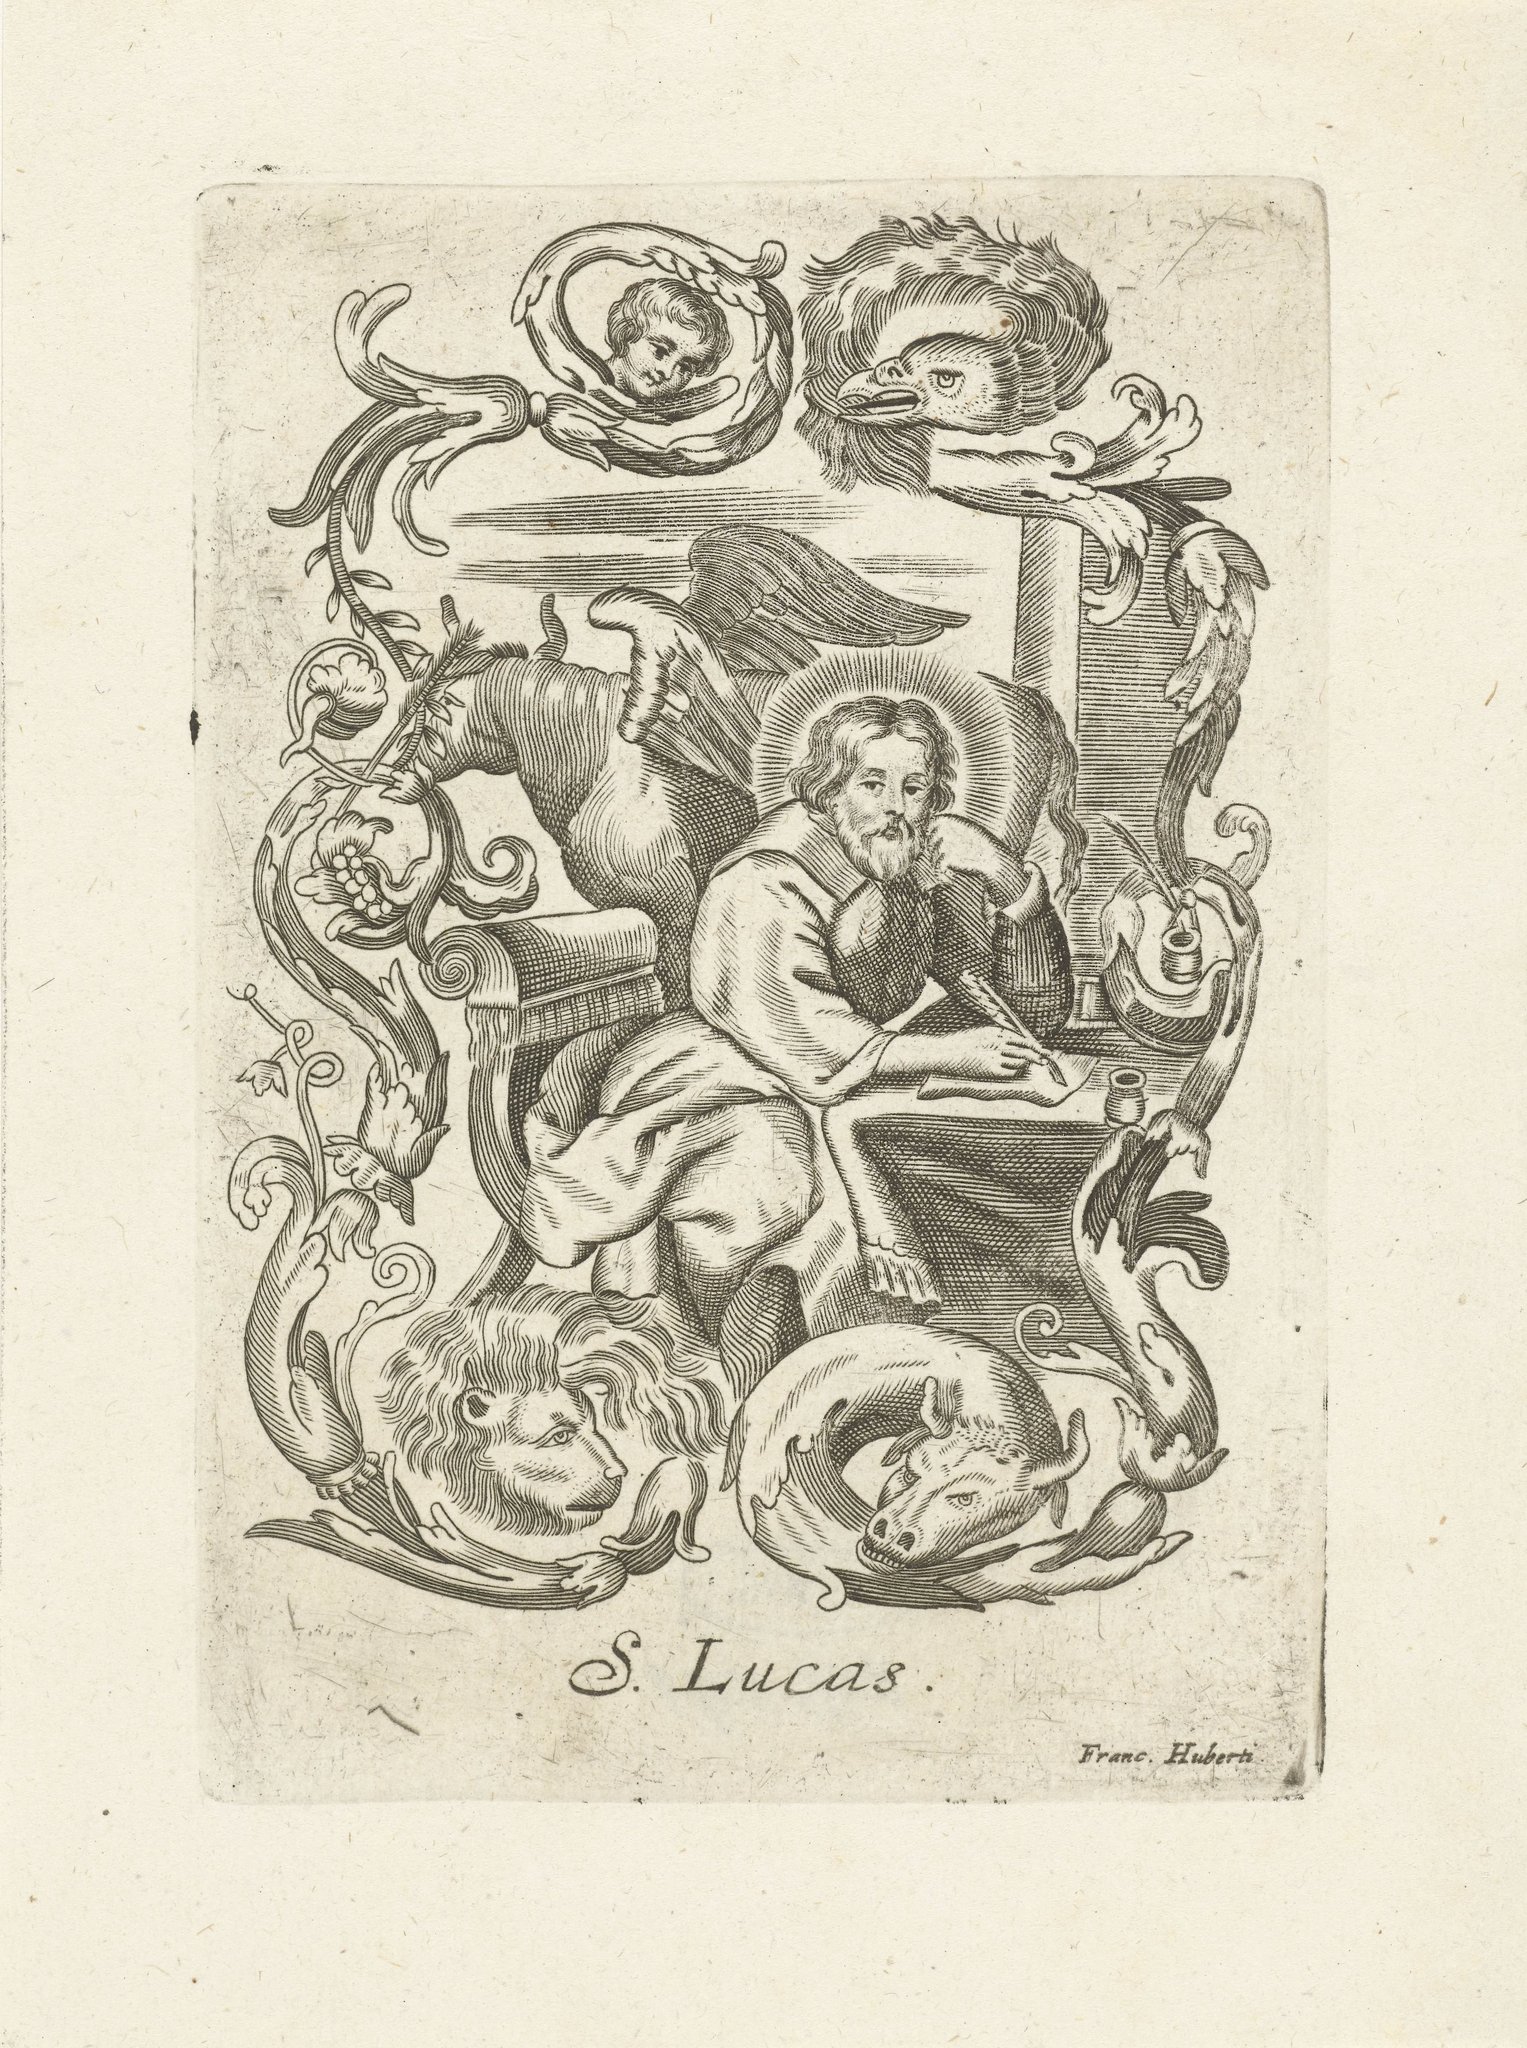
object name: print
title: S. Lucas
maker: franz huybrechts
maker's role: print maker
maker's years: 1630-1687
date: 1656-1661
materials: paper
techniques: engraving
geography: antwerp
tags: st. luke writing his gospel, usually a (winged) ox present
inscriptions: collector's mark: Lugt 2228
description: De evangelist Lucas zittend op een stoel en schrijvend aan een tafel. Achter hem staat een gevleugelde os. De voorstelling bevindt zich binnen een kader van ornamentwerk, waarin de attributen van de vier evangelisten zijn verwerkt. Boven een engelenhoofd en een adelaarskop, beneden een ossenkop en leeuwenkop.